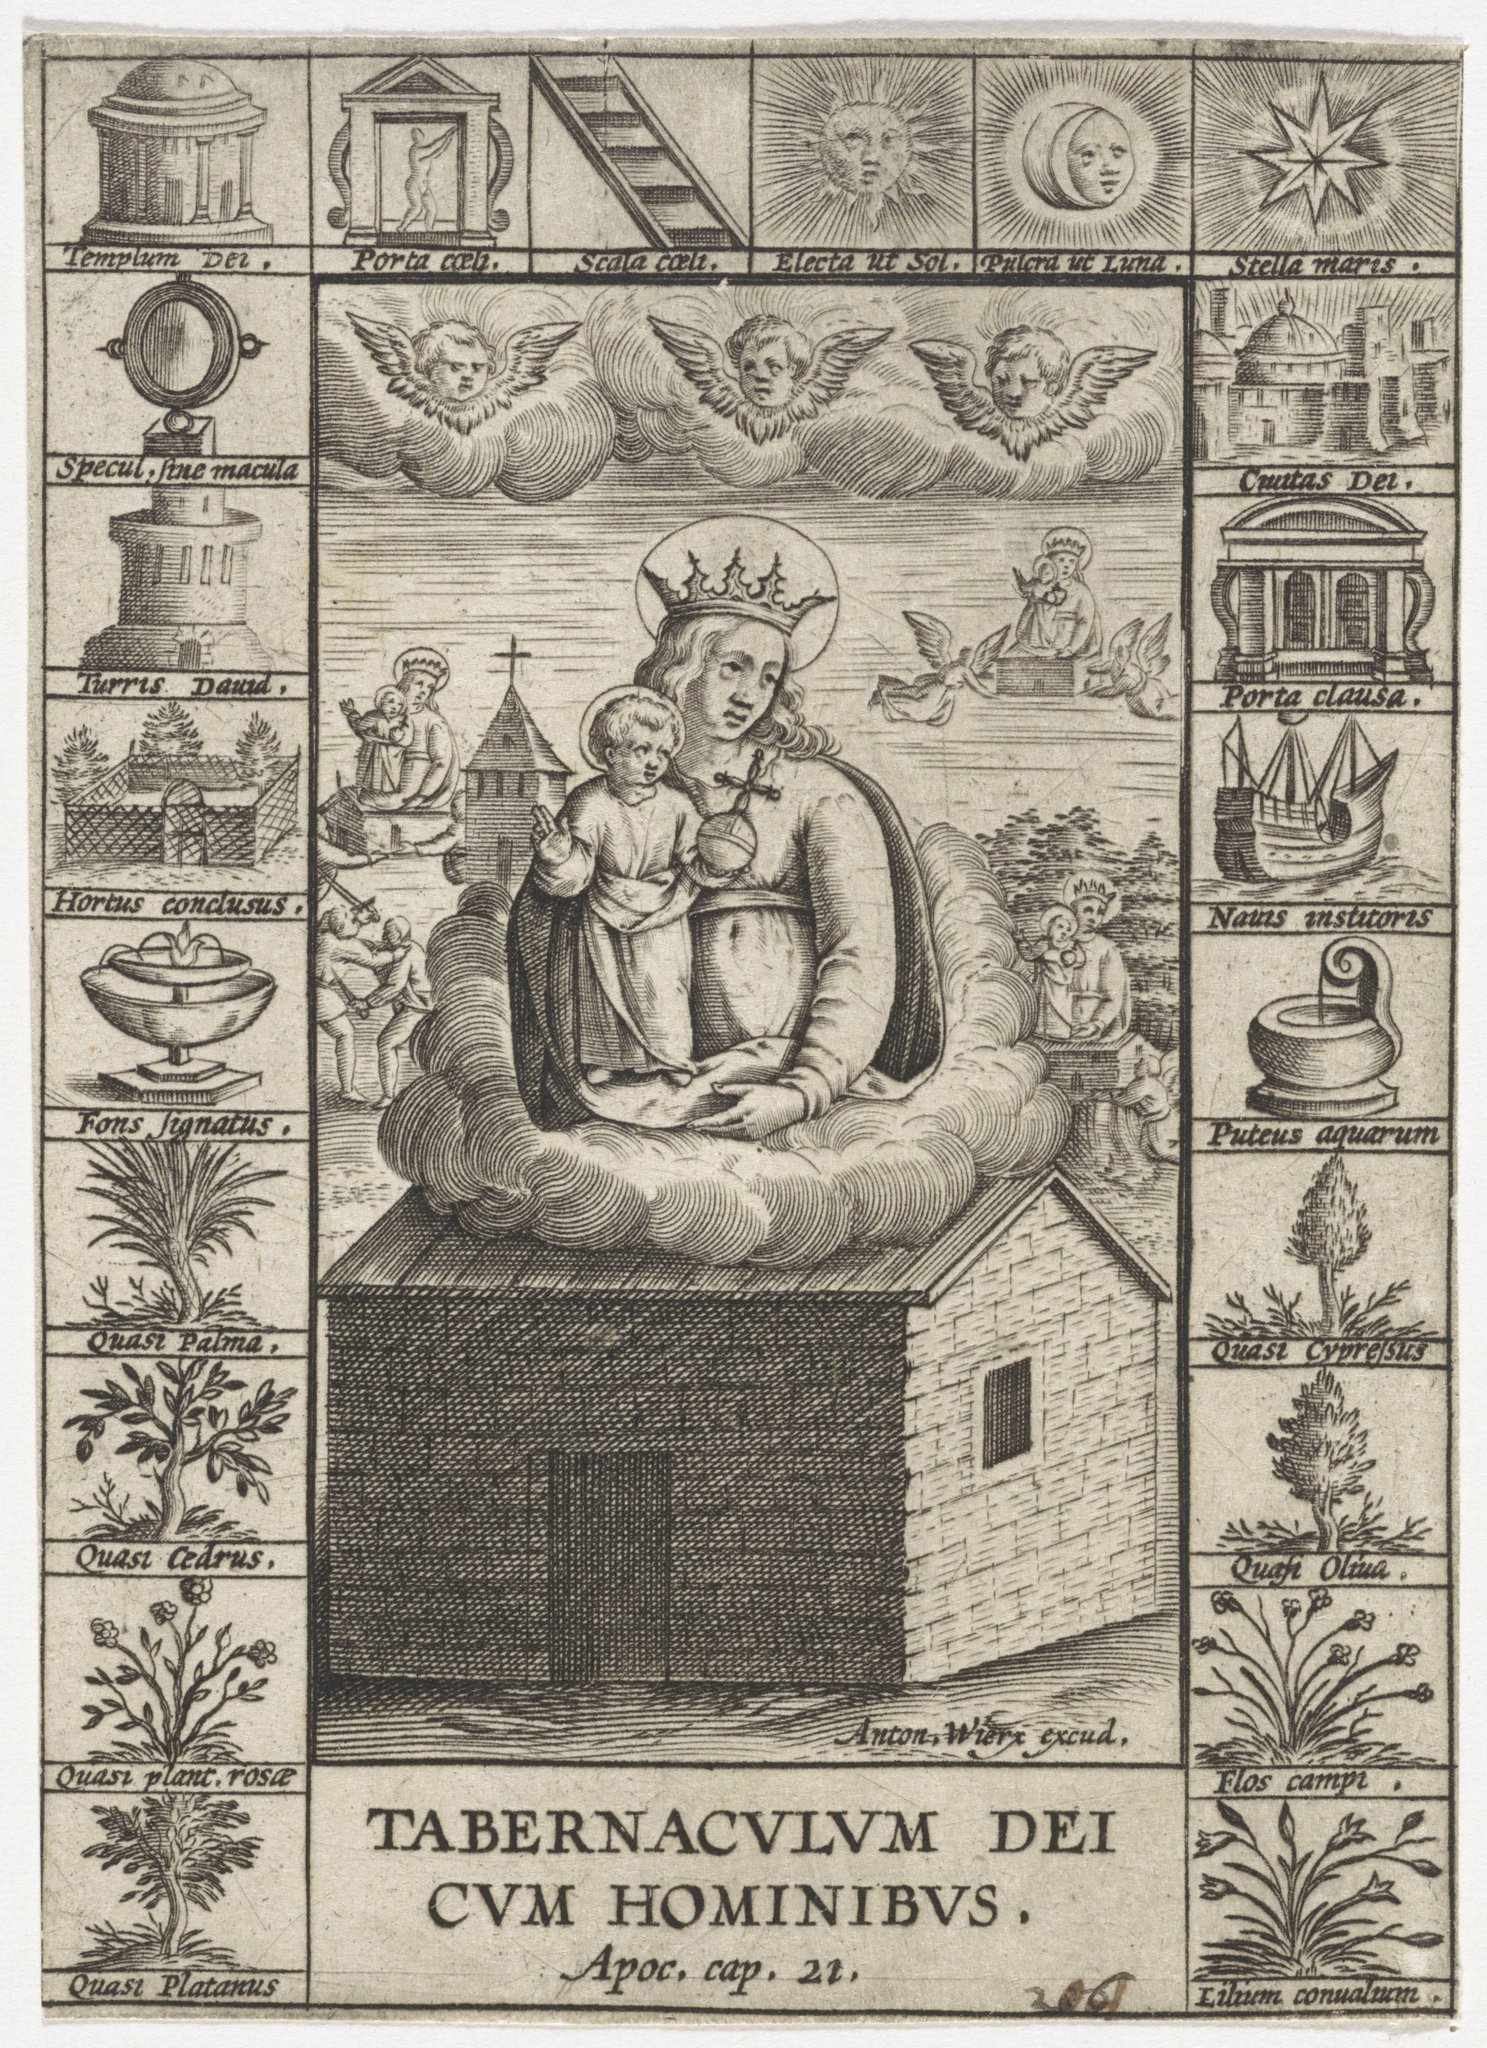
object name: print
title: Tabernacvlvm dei cvm hominibvs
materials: paper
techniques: engraving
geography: antwerp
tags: mary or madonna with symbols of the lauretanian litany, the house of nazareth which came to loreto (mary-miracle)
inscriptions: collector's mark: Lugt 2228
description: Maria zit met het Christuskind op het dak van een huis [van Maria en Jozef in Nazaret]. Op de achtergrond scènes waarin te zien is hoe engelen het huis in veiligheid brengen. Daarboven drie cherubijnen. De voorstelling is omlijst door 22 symbolen uit de Lauretaanse Litanie (Litanie van de heilige Maagd Maria).